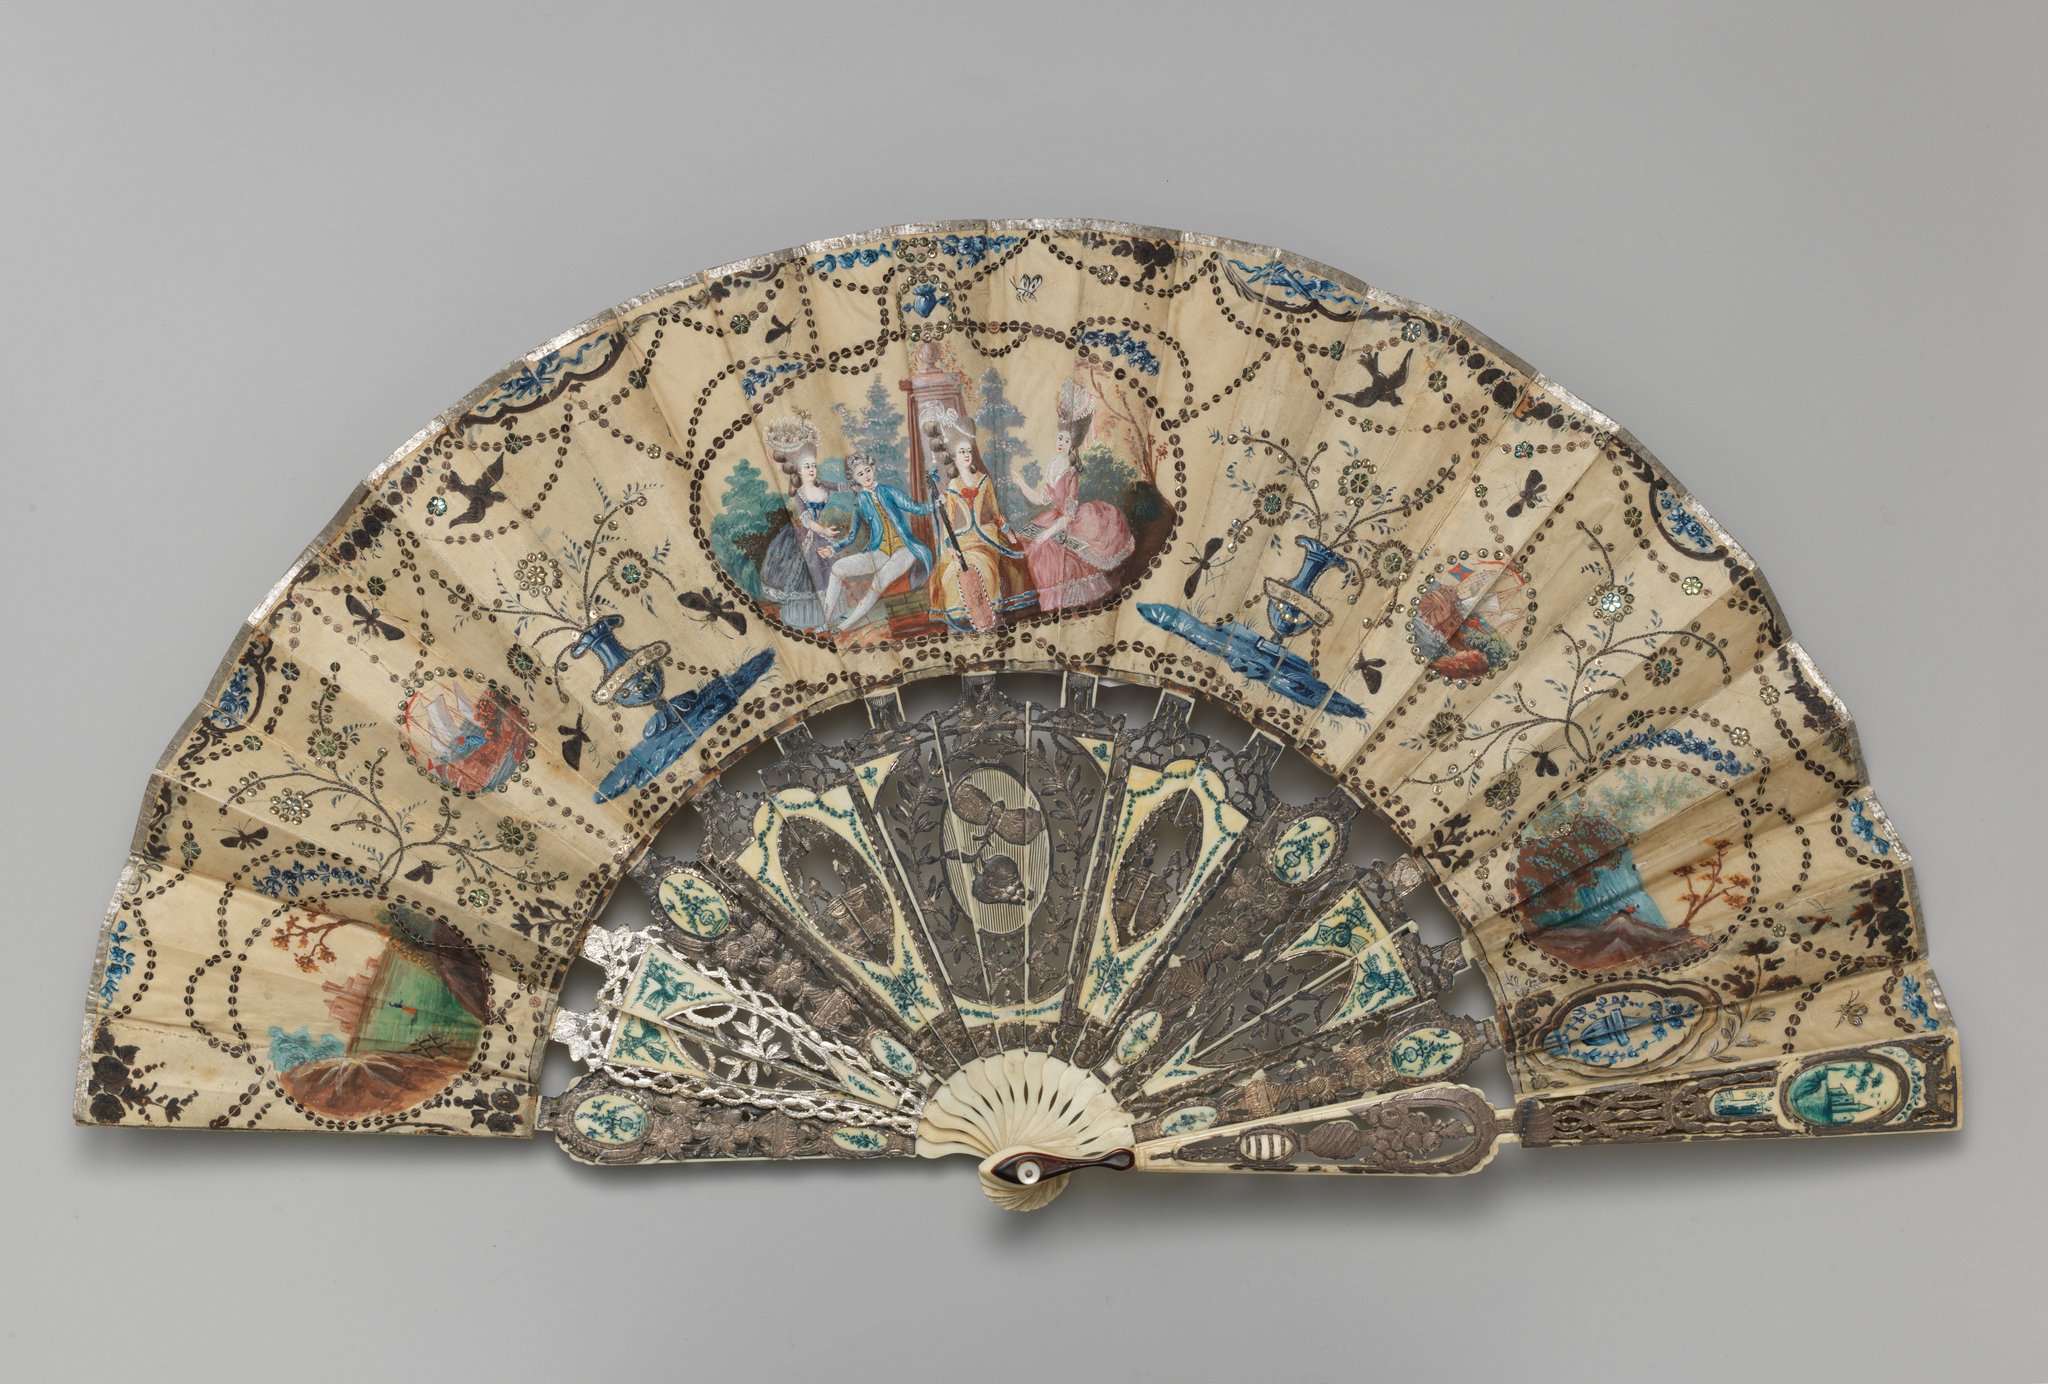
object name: fan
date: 1777-1780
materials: ivory, silk, silver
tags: birds,men,women,insects